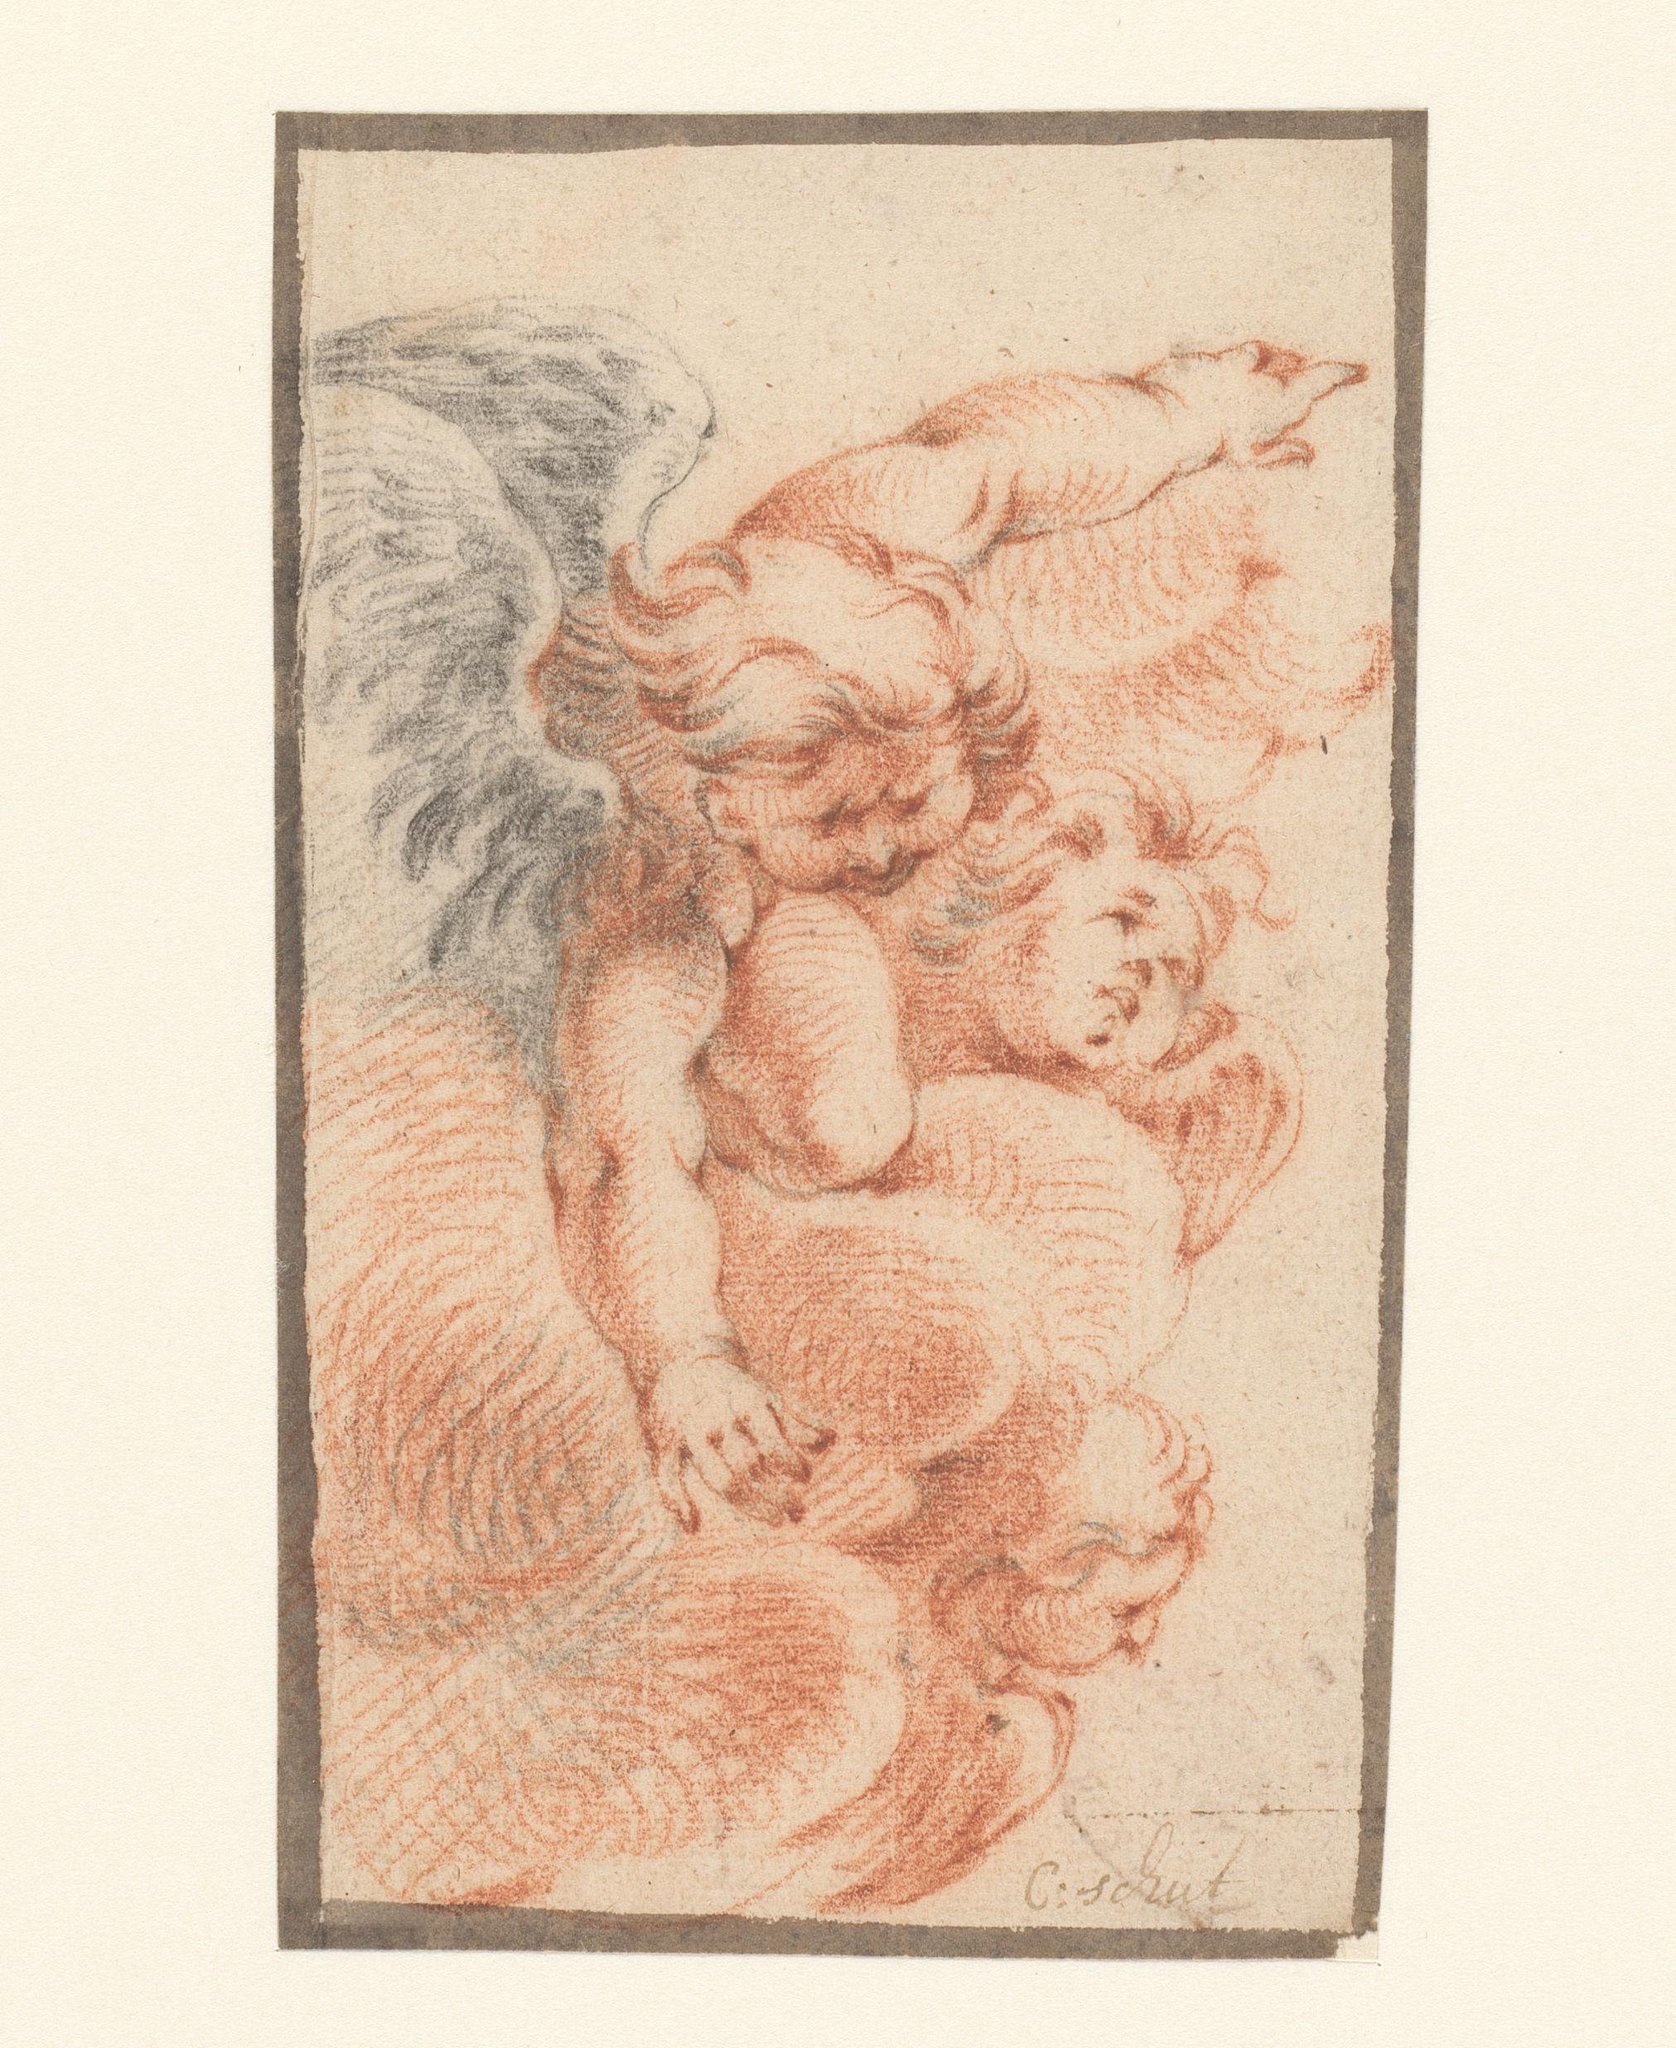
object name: drawing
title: Drie cherubijnen in een wolk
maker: cornelis schut (i)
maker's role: draughtsman, print maker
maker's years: 1597-1655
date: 1607-1655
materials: chalk, paper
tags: cherubs, i.e. children's heads with wings